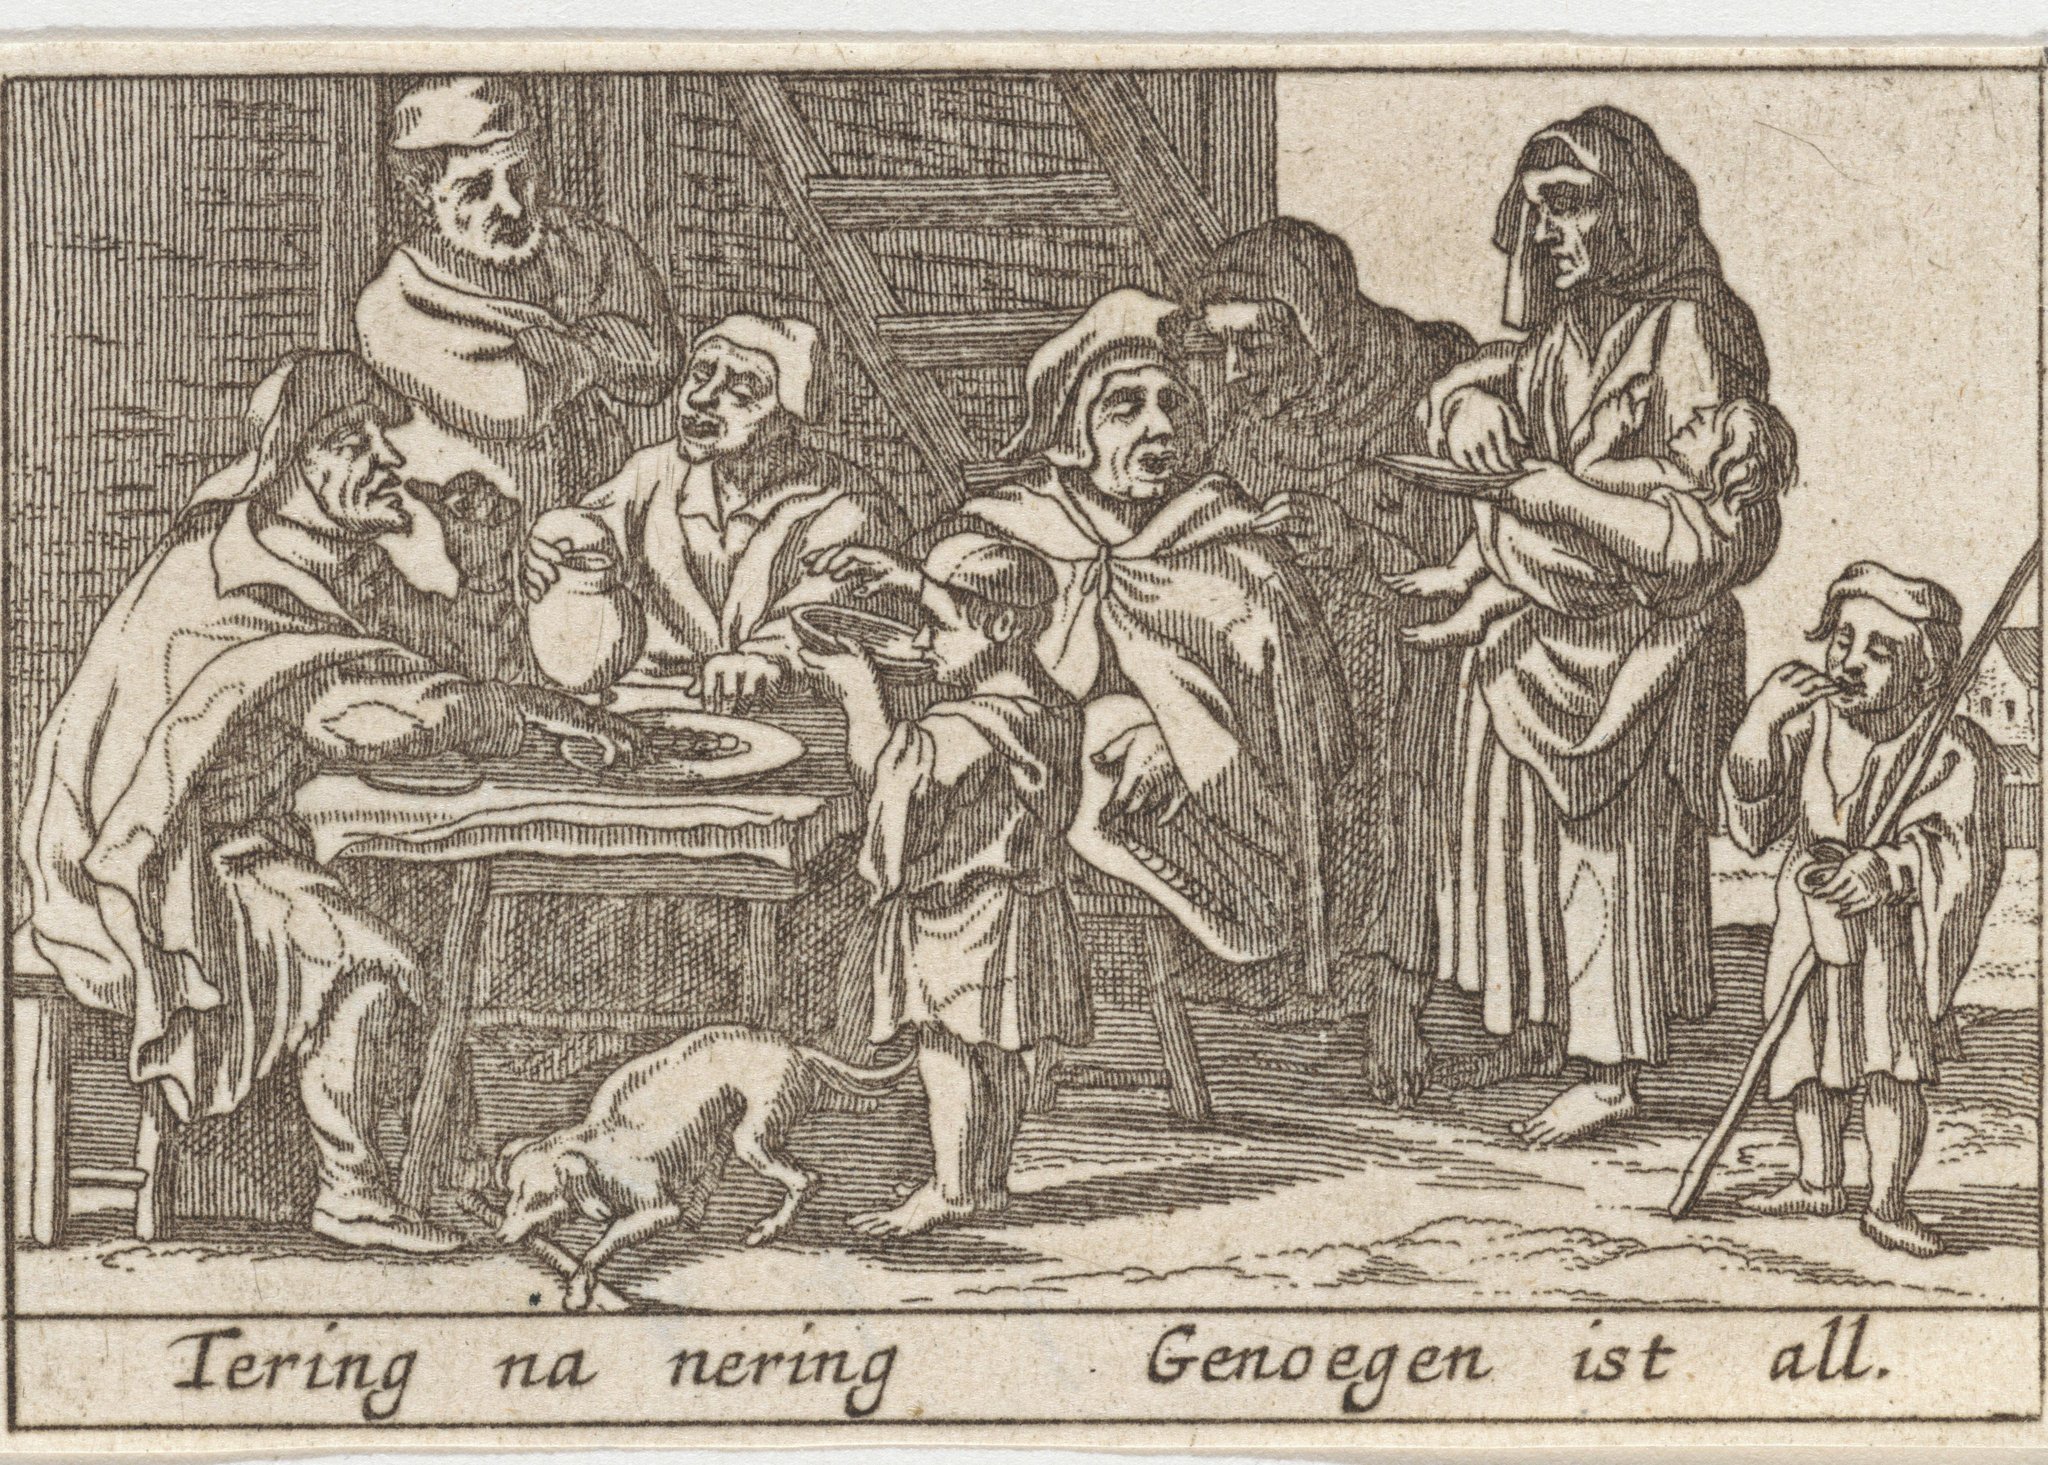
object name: print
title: Etende figuren rond een tafel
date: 1628-1650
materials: paper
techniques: etching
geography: amsterdam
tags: giving food, eating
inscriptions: collector's mark: Lugt 2228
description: Drie mannen etend en drinken om een tafel voor een huisje. Een kind drinkt uit een nap. Rechts twee vrouwen die iets vragen en een kind dat eet uit de hand.